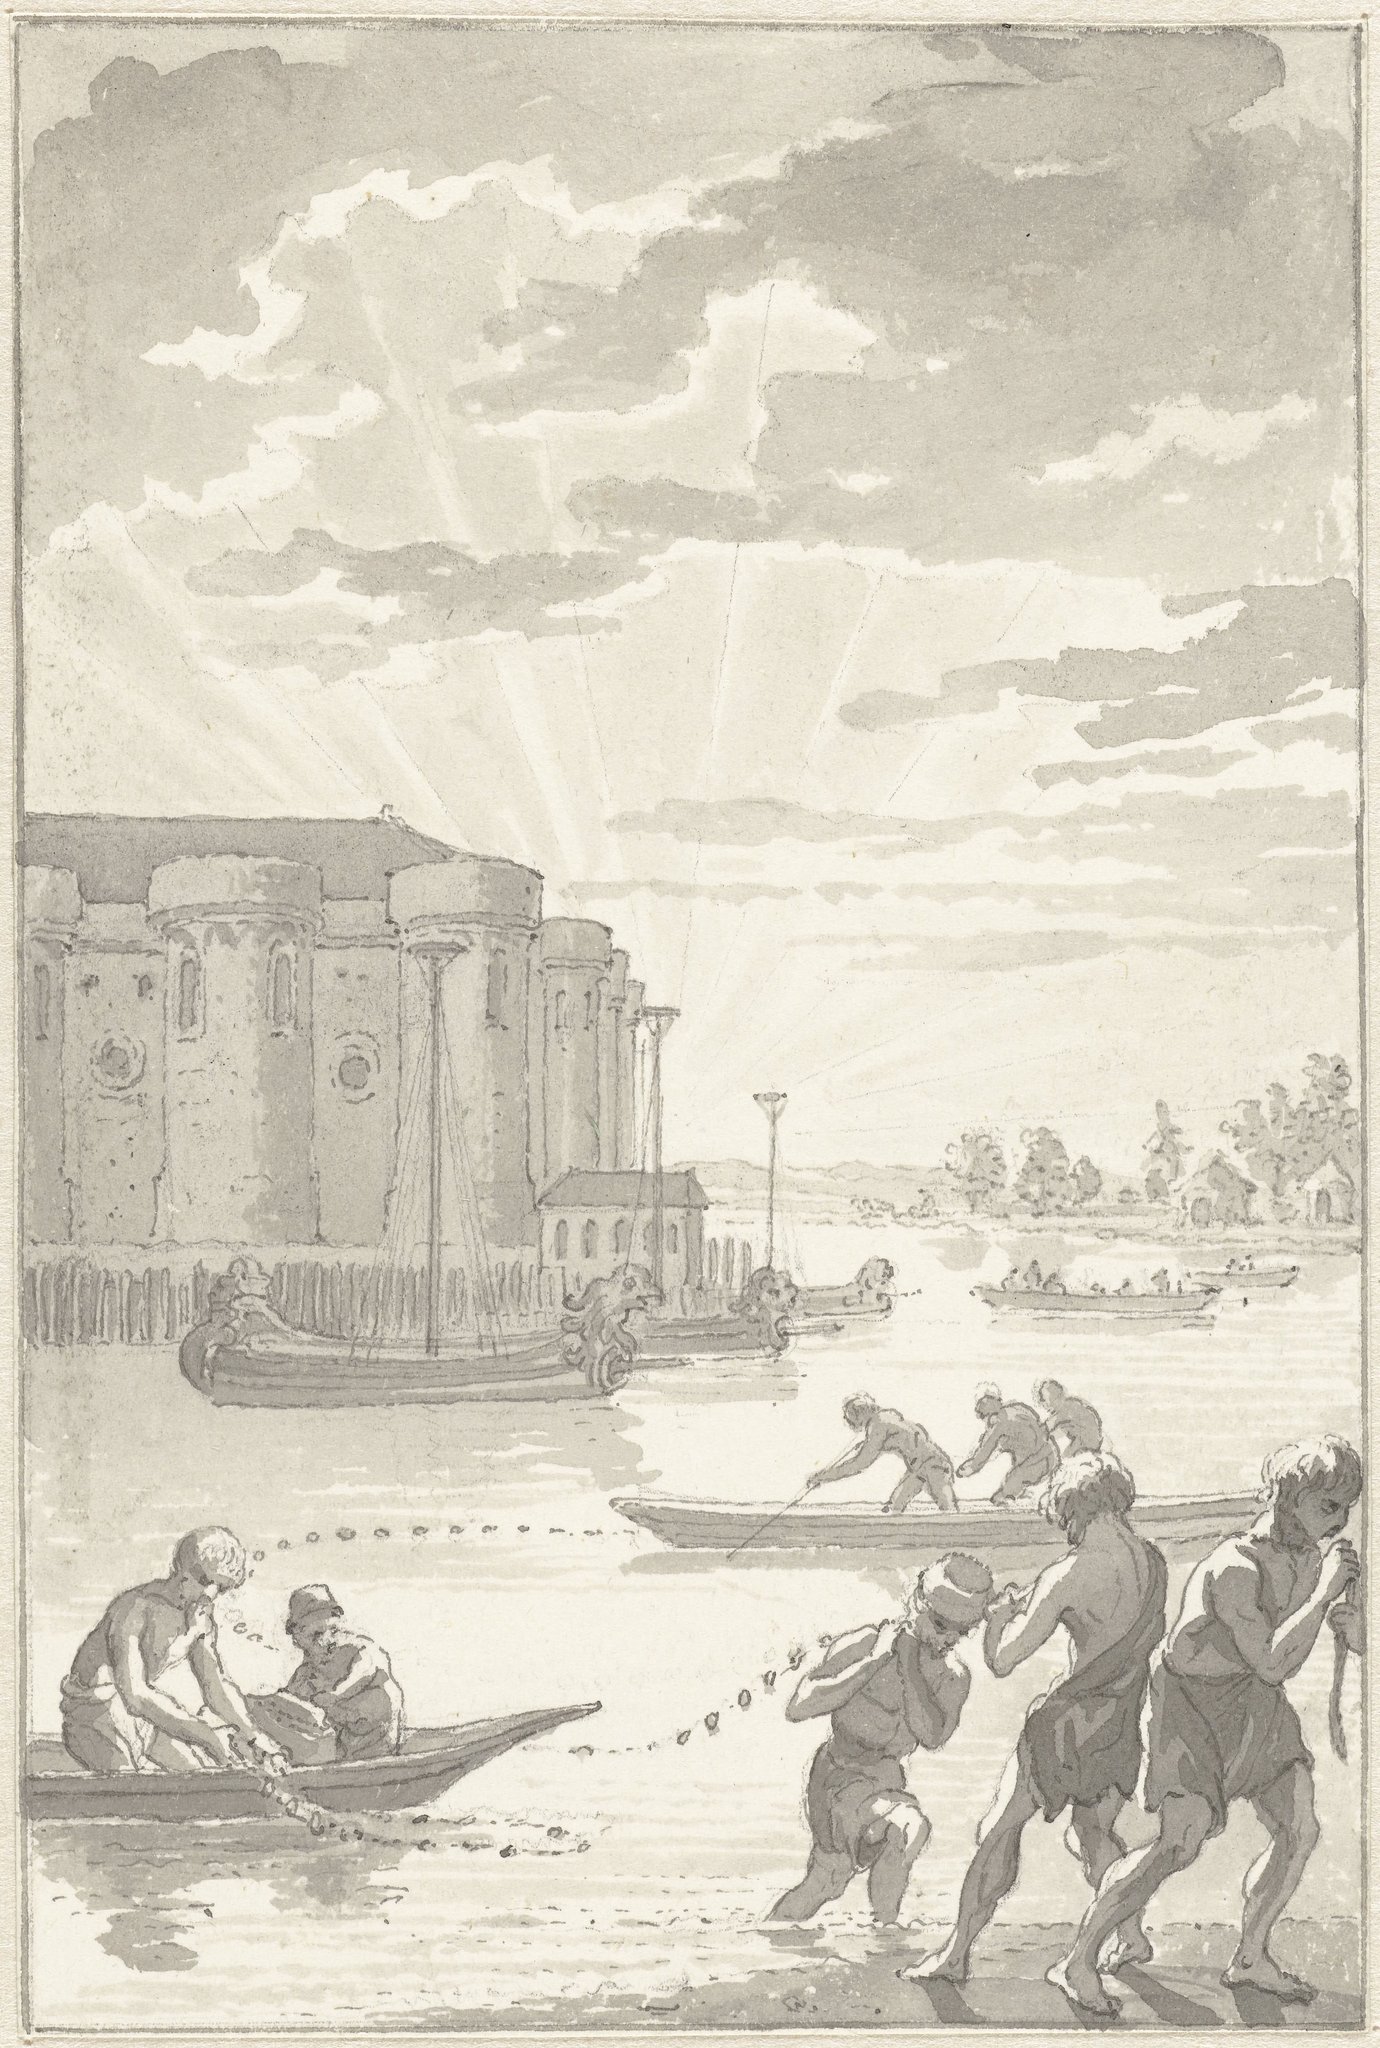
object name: history print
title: De Brittenburg bij Katwijk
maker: engelbertus matthias engelberts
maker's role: draughtsman, print maker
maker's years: 1731-1807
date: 1797-1799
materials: ink, paper, pencil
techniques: brush, pen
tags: fortress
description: Ontwerptekening voor illustratie in: E.M. Engelberts, De aloude staat en geschiedenissen der Vereenigde Nederlanden, Johannes Allart, Amsterdam 1784-1799, dl. IV, p. 298. Niet in Frederik Muller; door het RPK toegevoegd nummer.